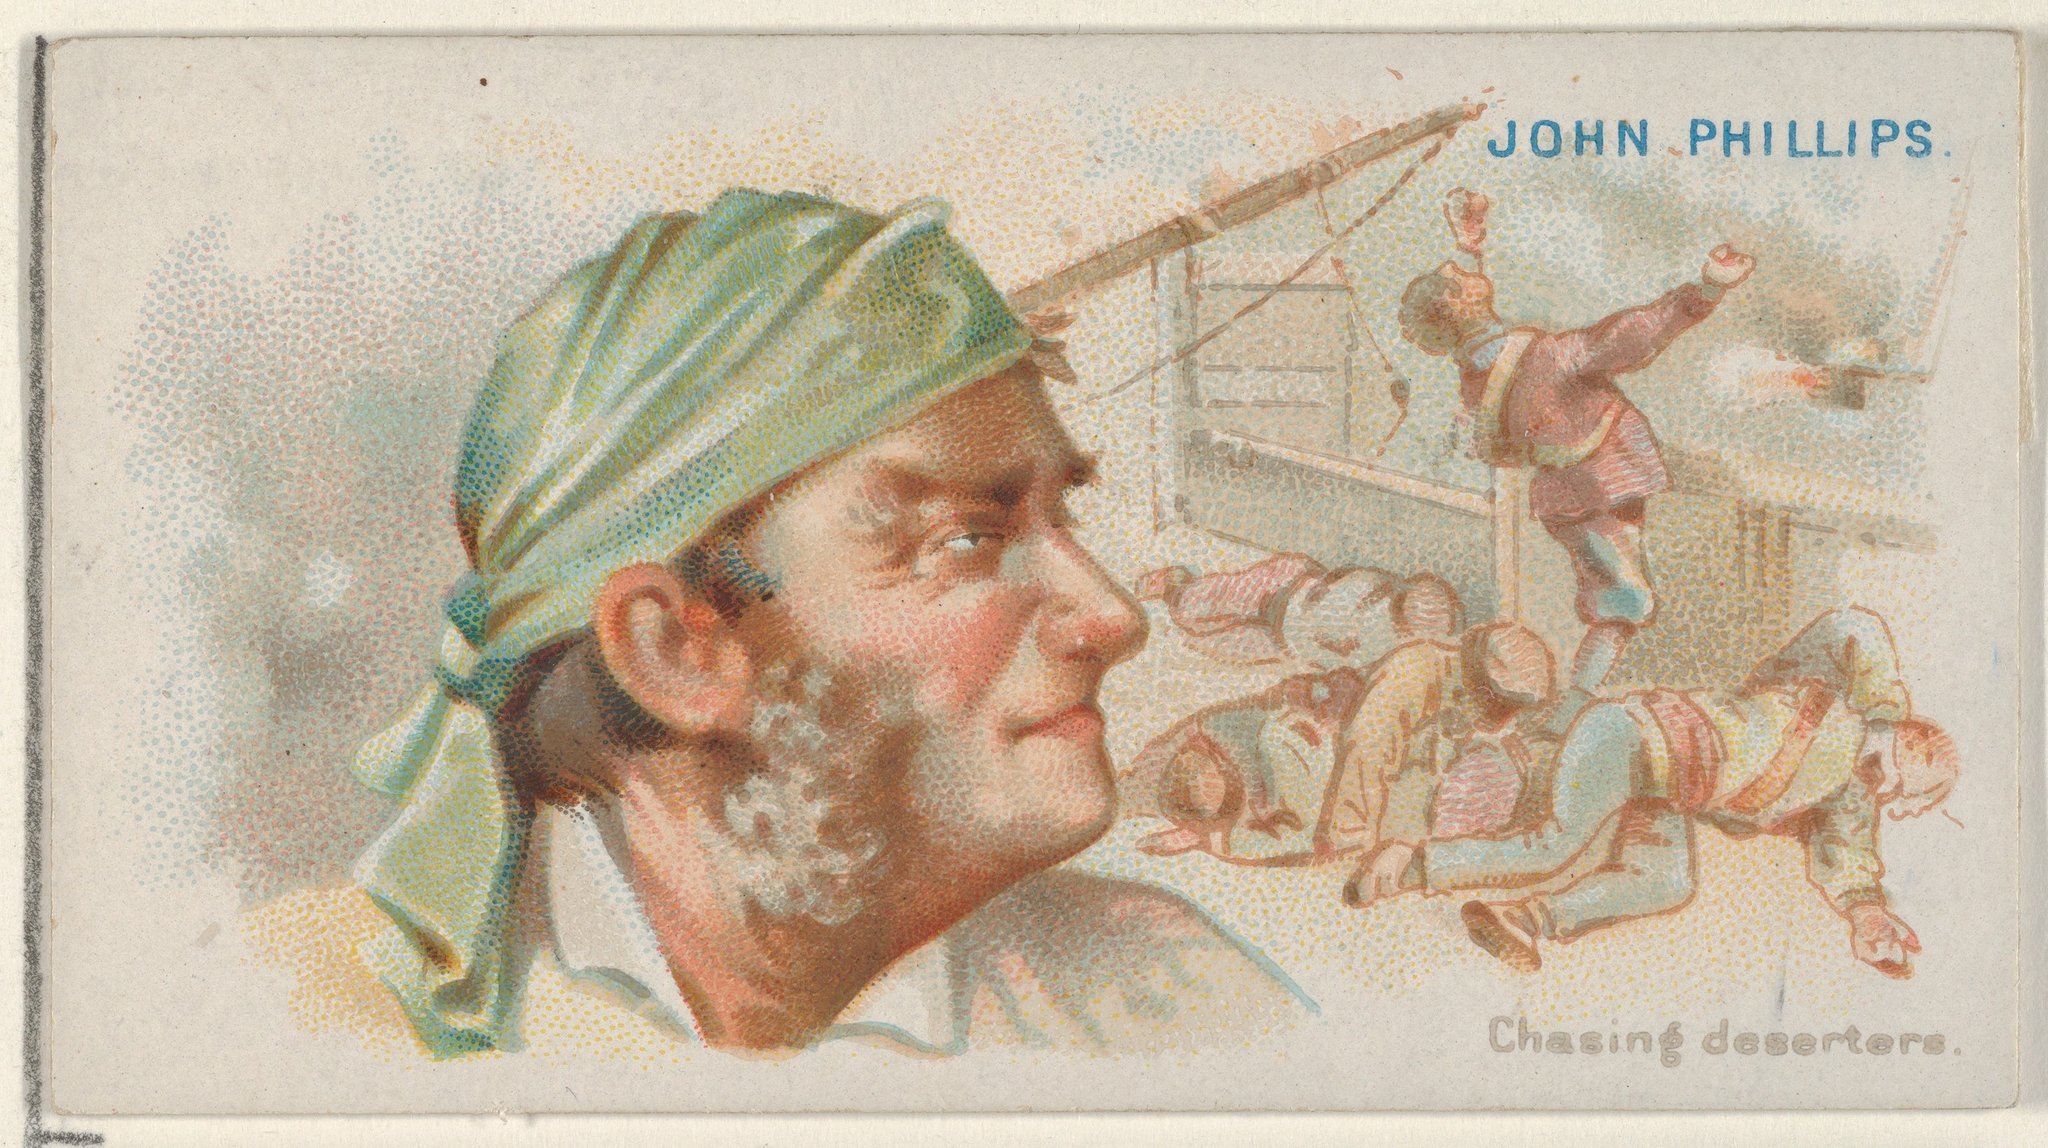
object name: print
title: John Phillips, Chasing Deserters, from the Pirates of the Spanish Main series (N19) for Allen & Ginter Cigarettes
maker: allen & ginter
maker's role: publisher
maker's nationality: american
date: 1888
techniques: color lithograph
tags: men,profiles